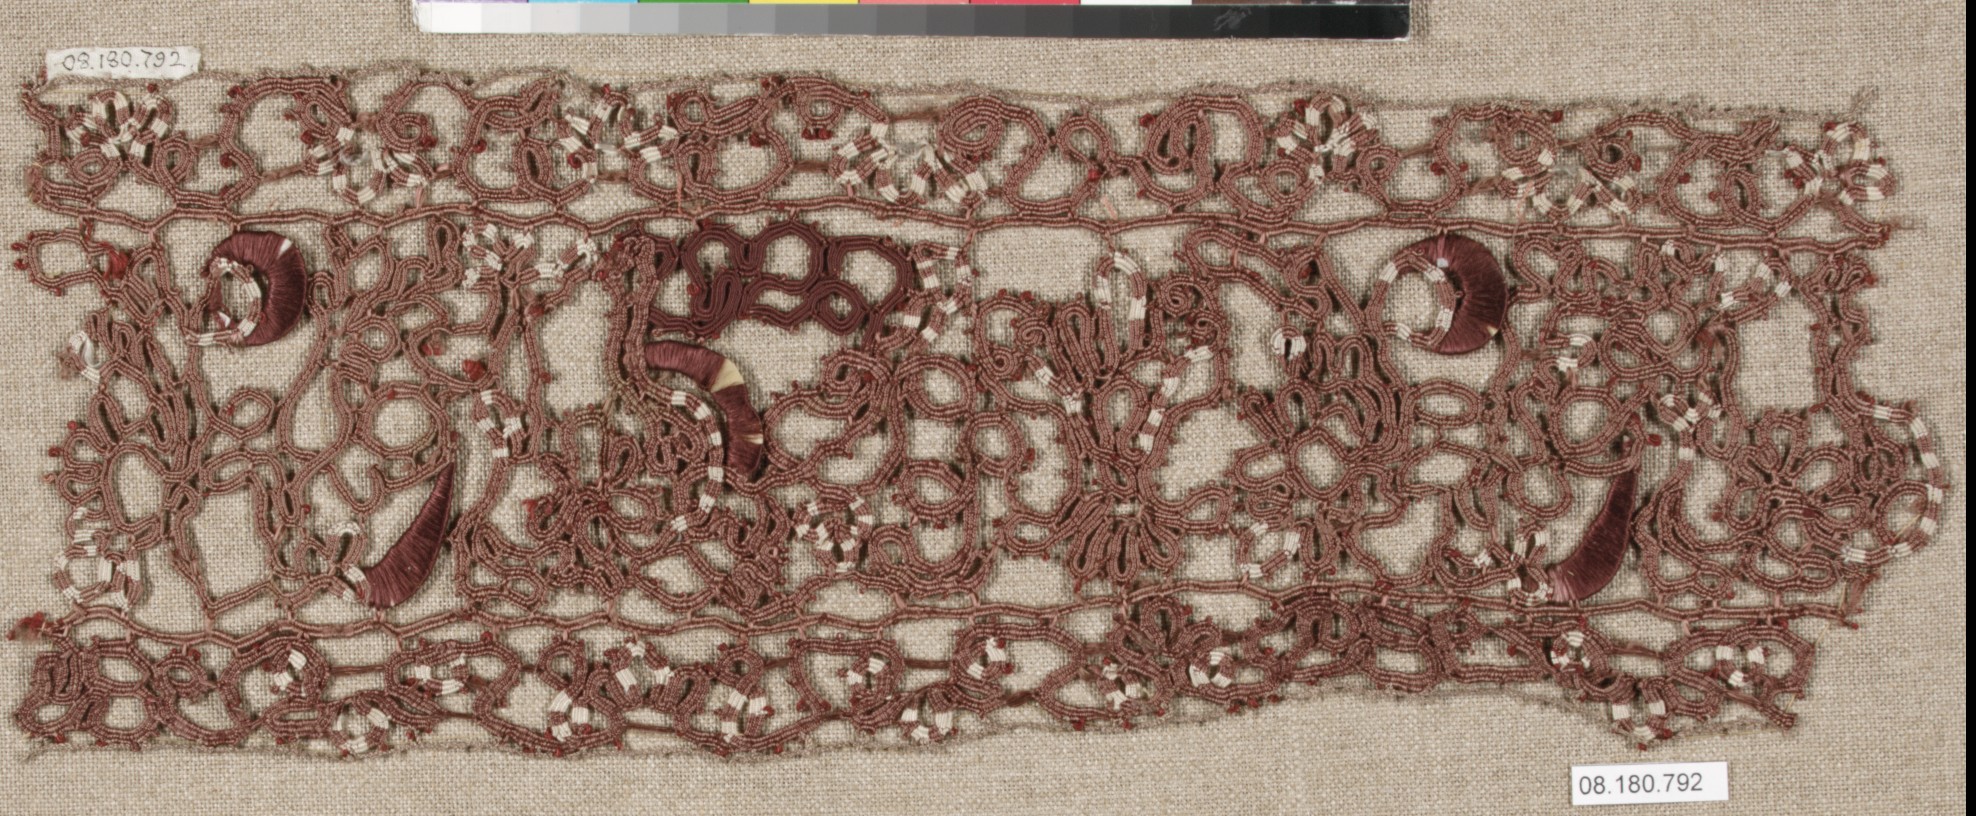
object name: passementerie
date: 1601-1700